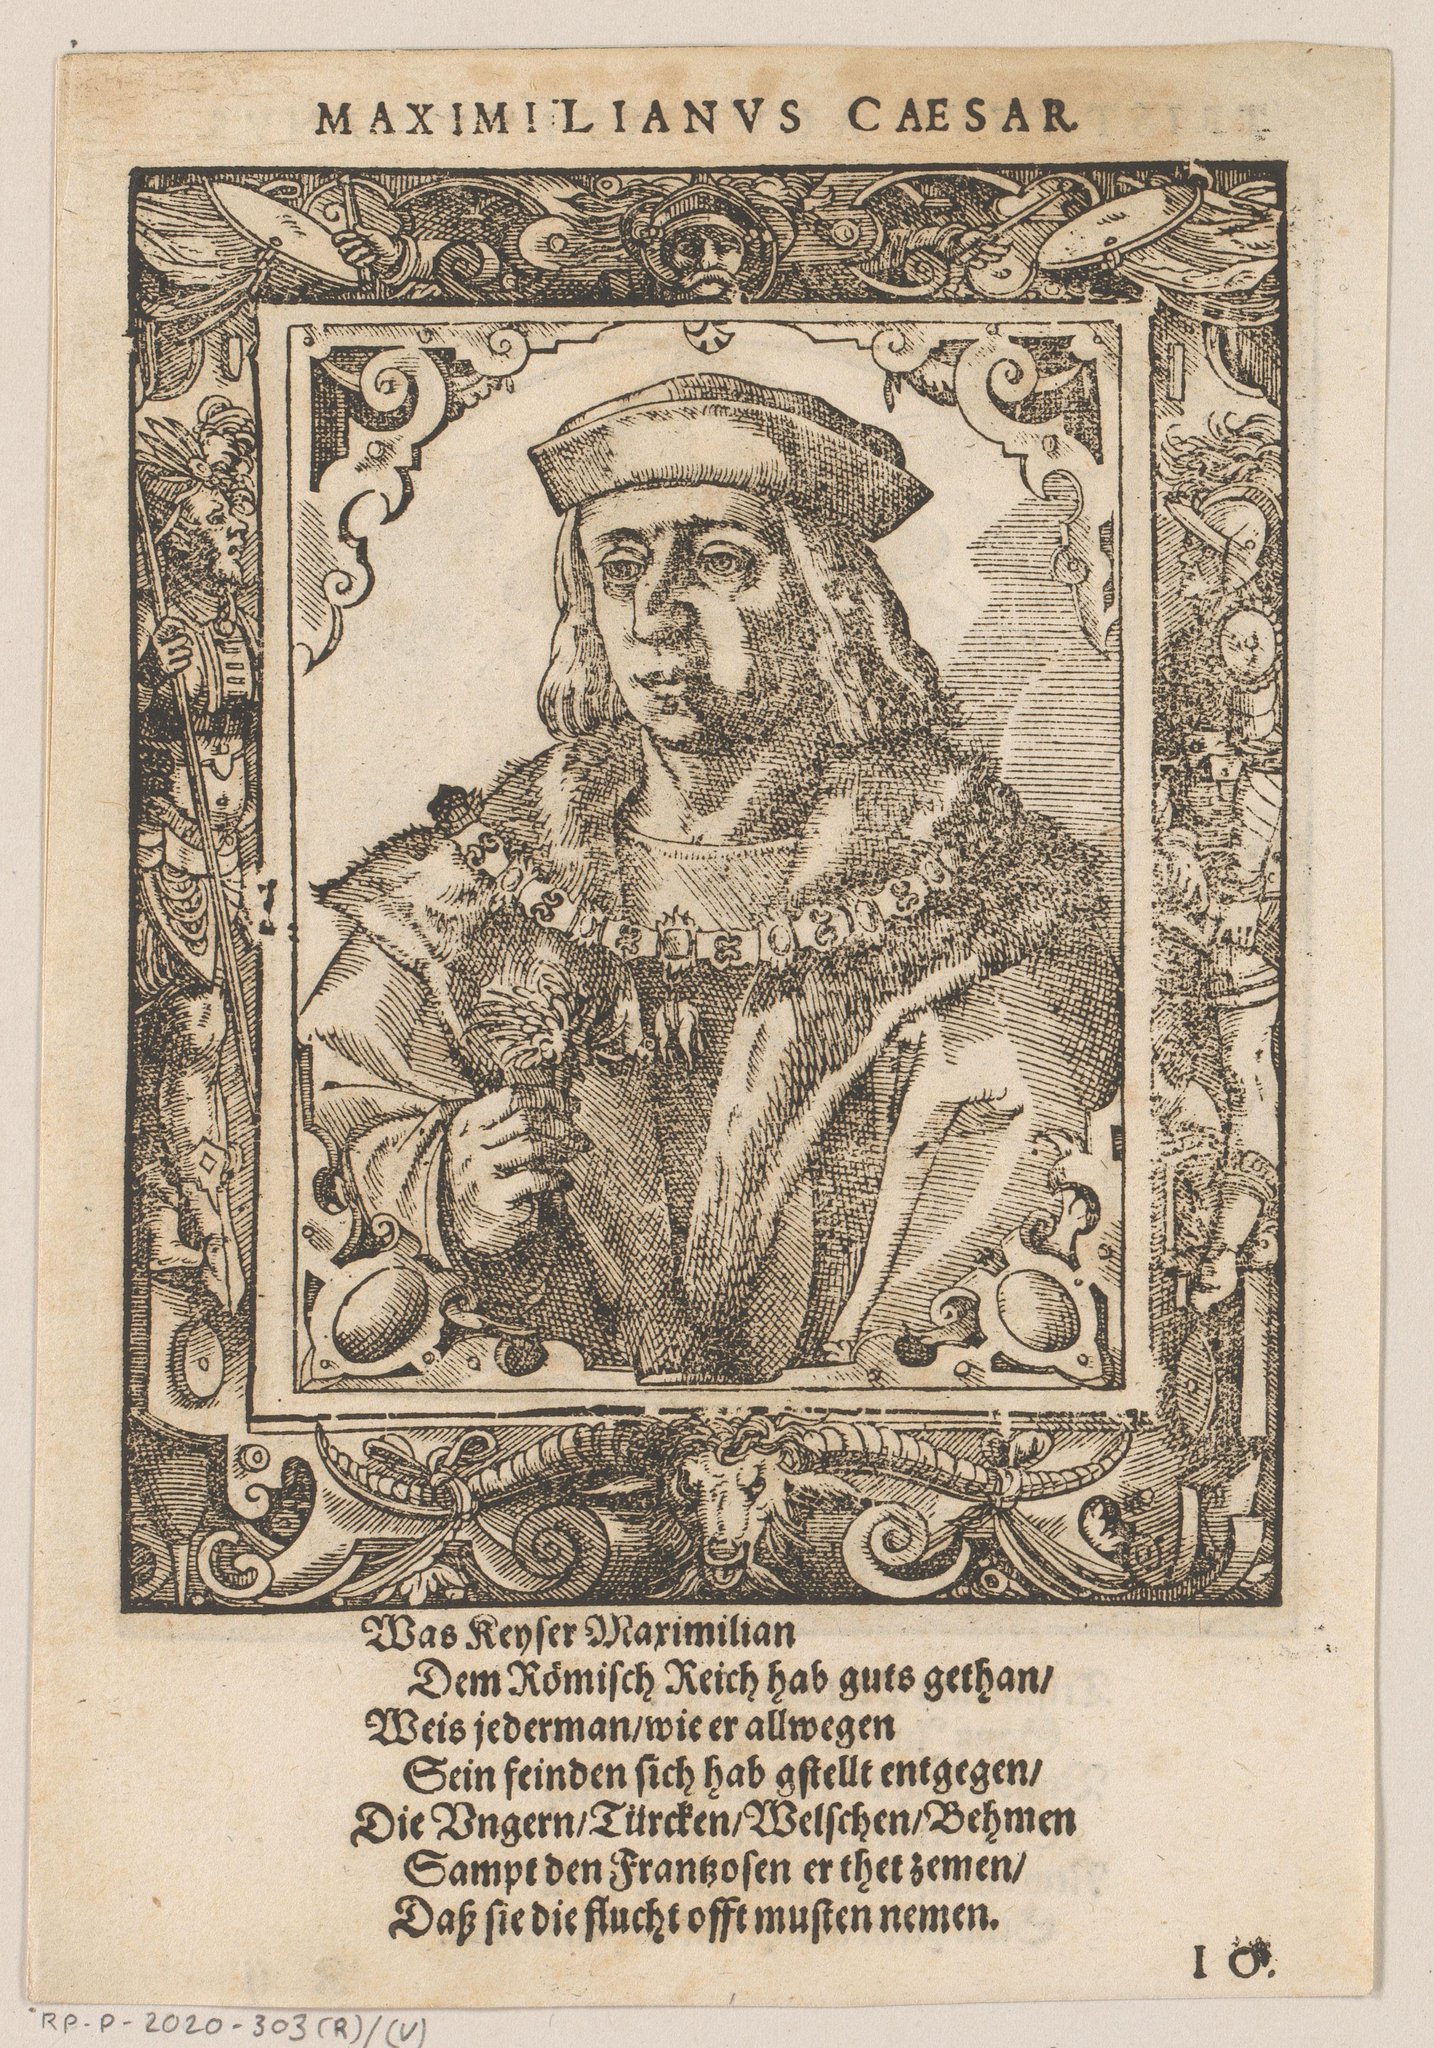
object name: book illustration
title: Portret van keizer Maximiliaan I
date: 1577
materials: paper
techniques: letterpress printing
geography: basel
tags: maximilian i (holy roman emperor), historical persons, emperor, knighthood order of the golden fleece - insignia of a knighthood order, e.g.: badge, chain (with name of order)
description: Prent uit: Müller, Theobald. Eigentliche und gedenkwürdige Contrafacturen oder Anbildungen wolverdienter unnd Weitberümter Kriegshelden, (...). Bazel: Peter Perna, 1577. Prent eerder verschenen in: Giovio, Paolo. Elogia virorum bellica virtute illustrium (...). Bazel: Peter Perna, 1575. Prent ook gebruikt in latere publicaties.